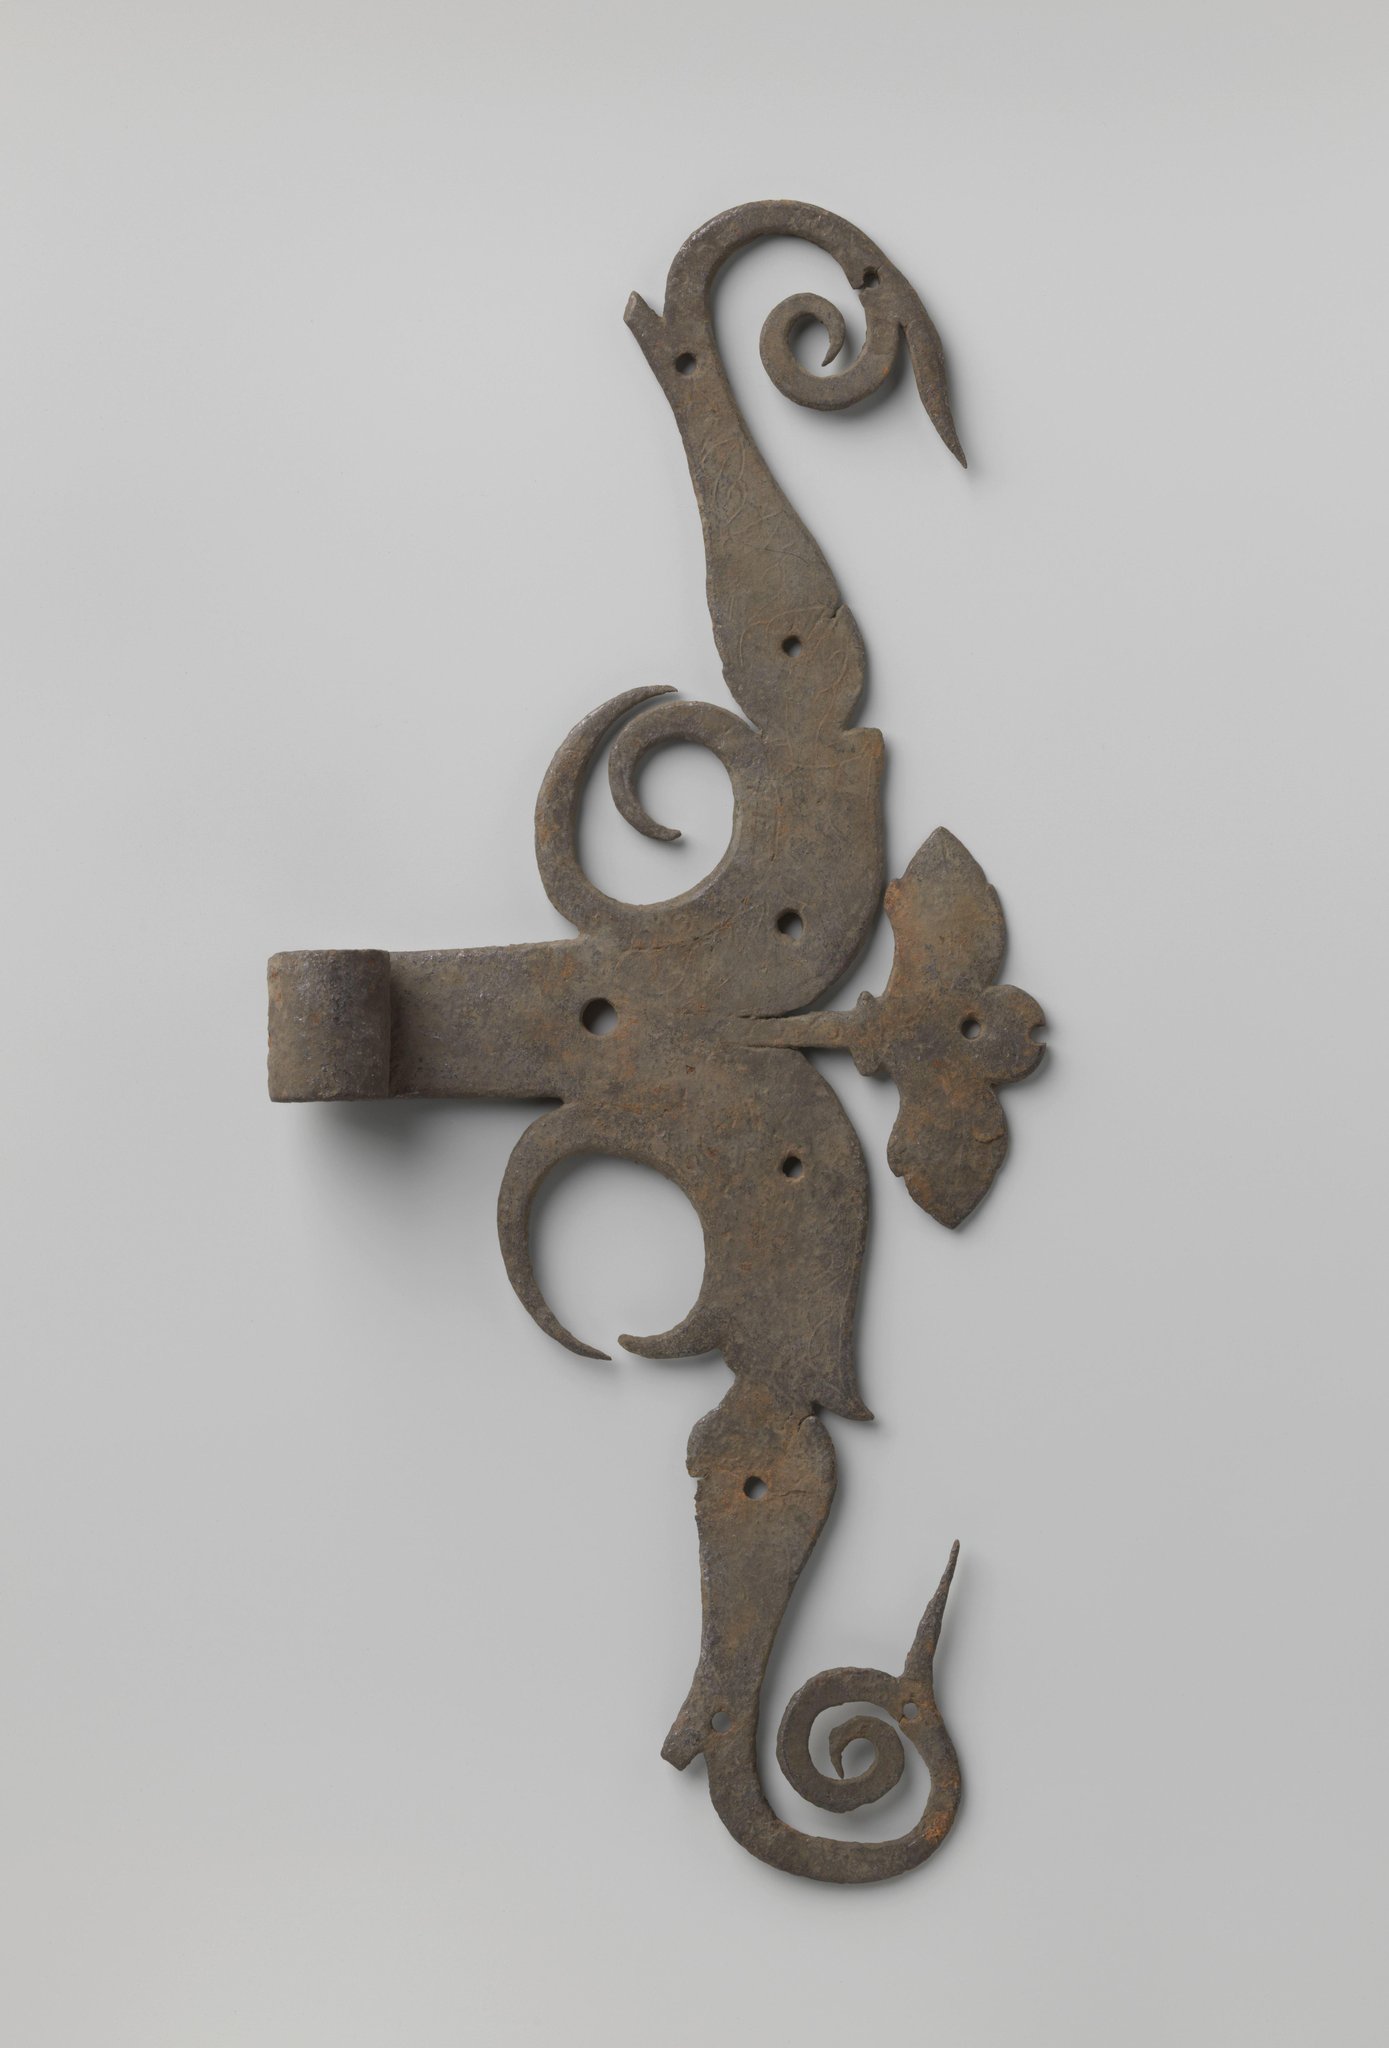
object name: deurhengsel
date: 1400-1950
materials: iron